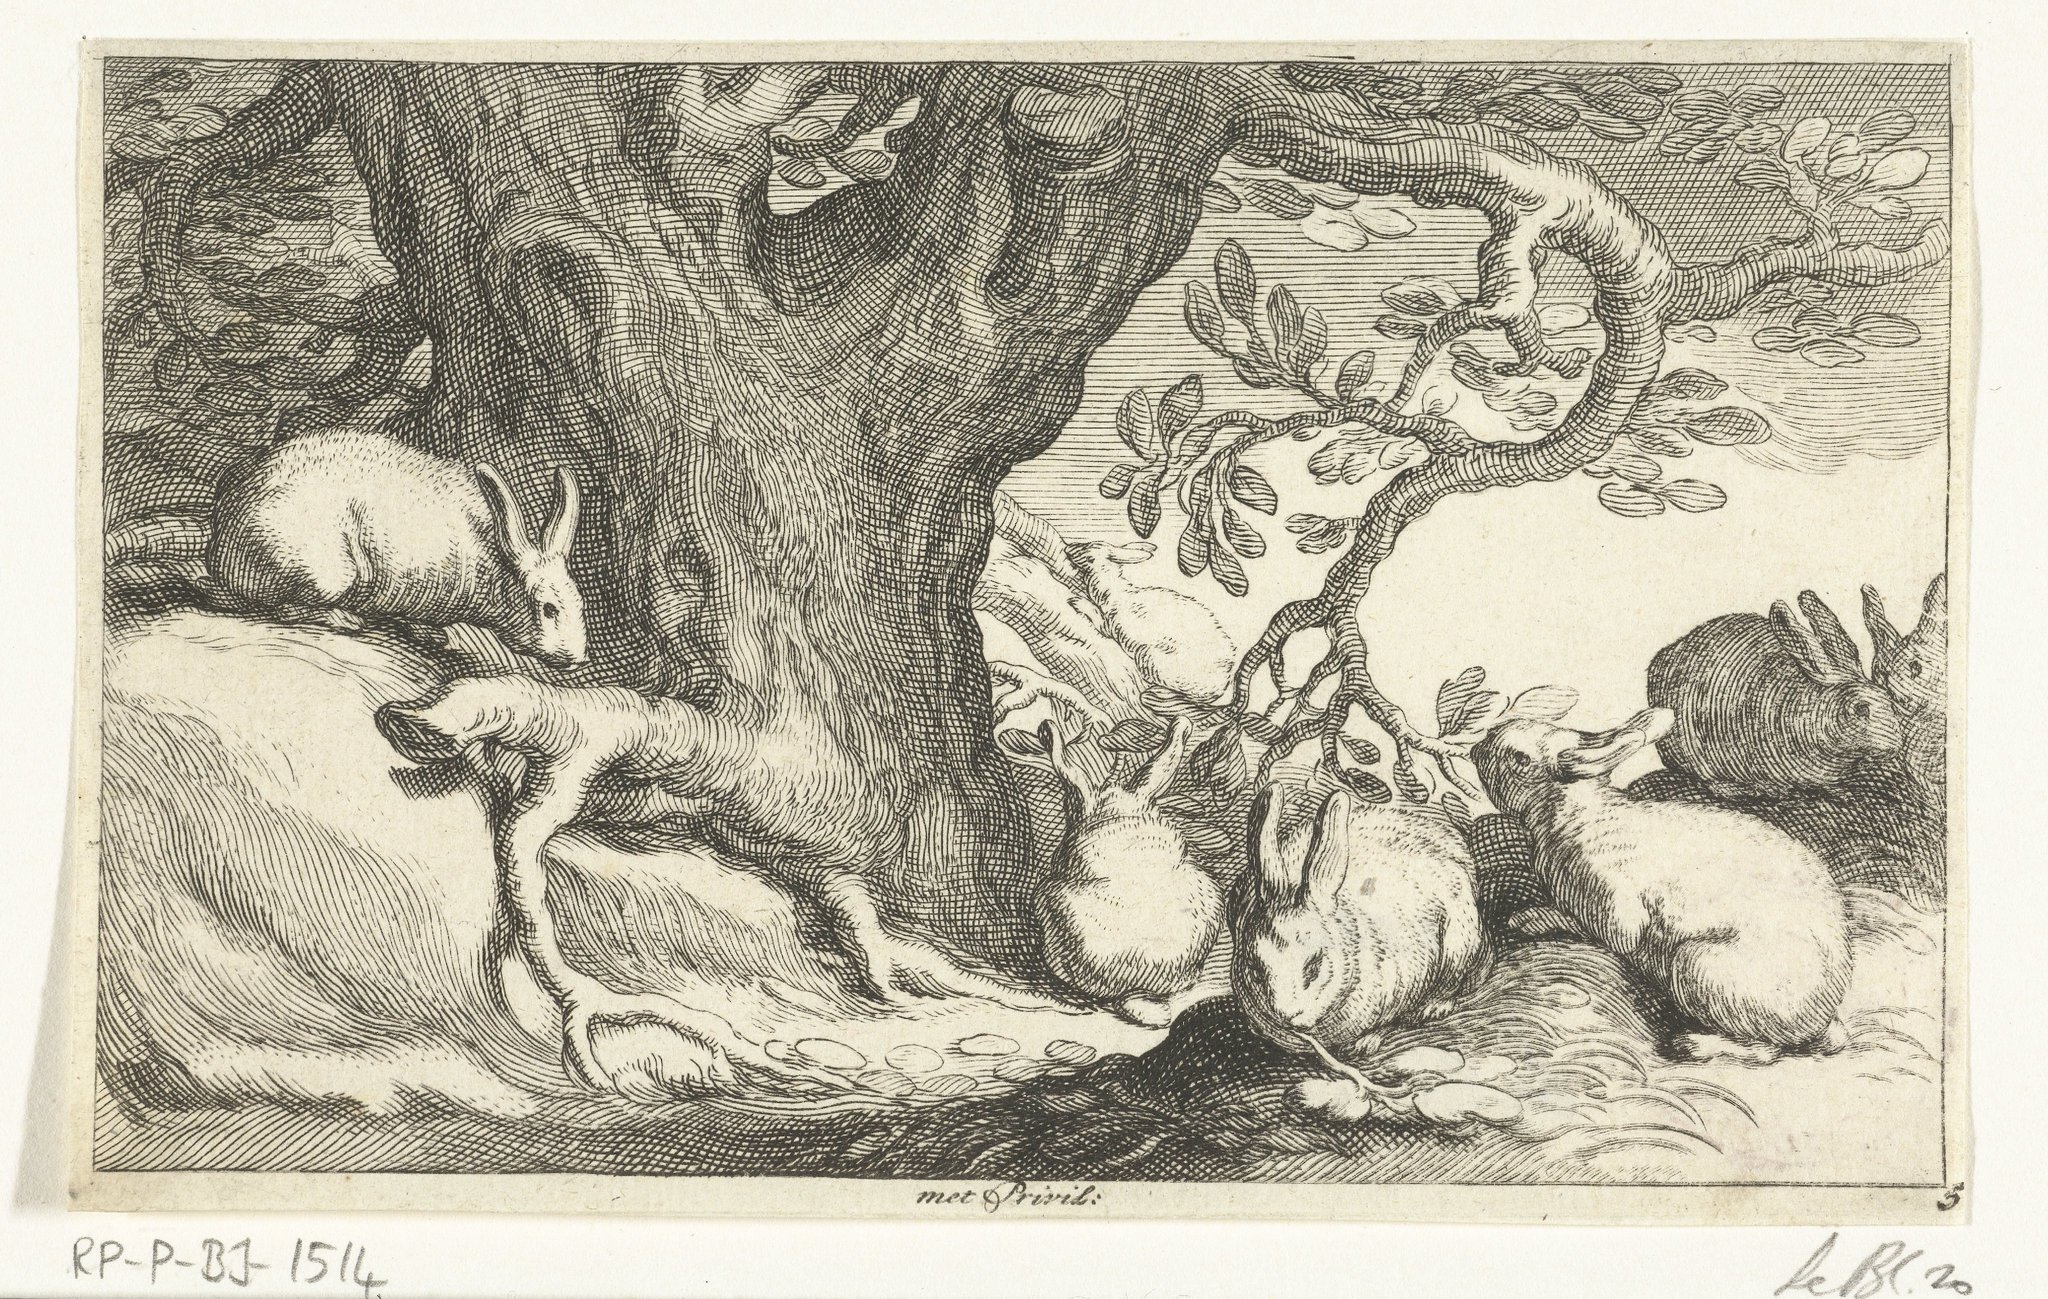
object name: print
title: Konijnen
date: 1635-1670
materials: paper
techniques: engraving, etching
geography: utrecht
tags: rodents: hare, rodents: rabbit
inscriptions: collector's mark: Lugt 240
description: Een stel konijnen zit aan de voeten van een boom. Prent uit een serie van 14 prenten met verschillende inheemse dieren.